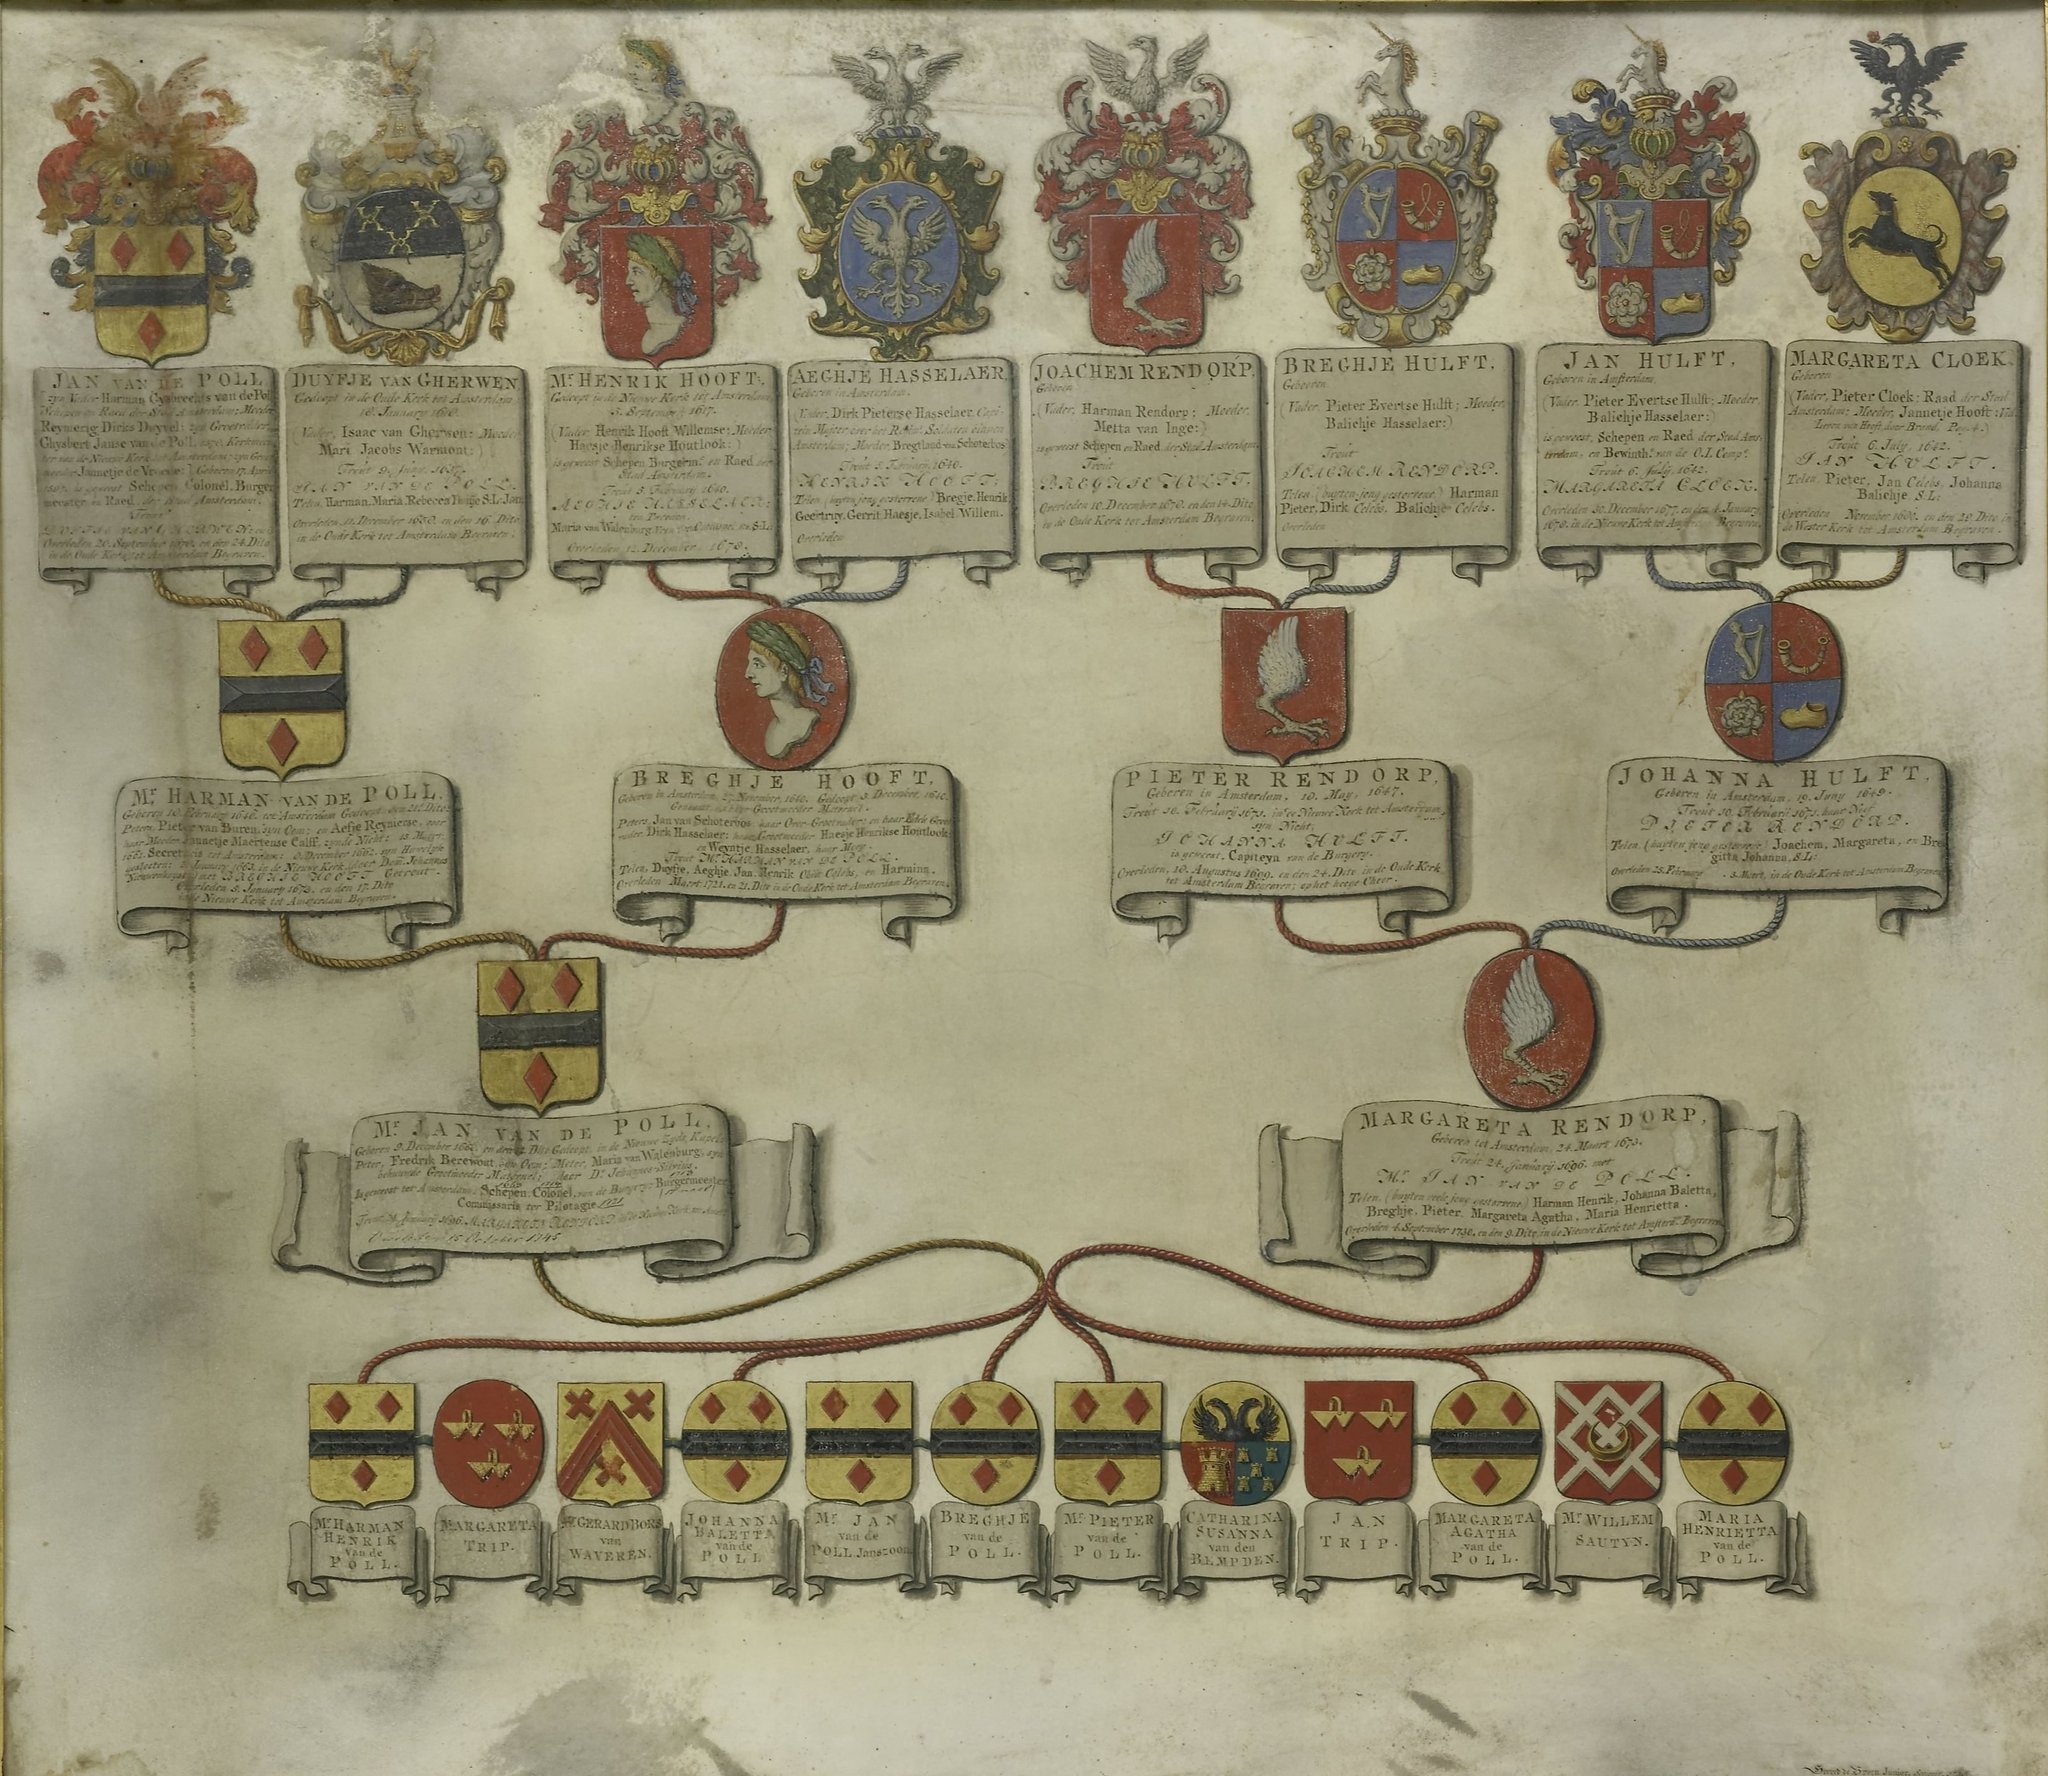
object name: heraldisch object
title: Wapenkaart met de wapens van de zes kinderen van Jan van de Poll en Margaretha Rendorp en die van hun echtgenoten; en hun kwartierstaat met acht kwartieren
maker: gerrit de broen (ii)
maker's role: print maker, publisher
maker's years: 1692-1774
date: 1738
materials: ink, parchment, watercolor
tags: amsterdam, mayor, family lineage, pedigree, genealogical tree or table, armorial bearing, heraldry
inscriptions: signature and date: ‘Gerred de Broen Junior Scripsit 1738’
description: Wapenkaart versierd met de wapens van de zes kinderen van Jan van de Poll (1668-1745) en Margaretha Rendorp (1673-1730) en die van hun echtgenoten: Trip, Bors van Waveren, van de Poll, van den Bempden, Trip en Sautijn; en hun kwartierstaat met acht kwartieren: van de Poll, van Gherwen, Hooft, Hasselaer, Rendorp, Hulft en Cloek. Onderdeel van een groep van drie wapens behorend bij de schenking J.S.R. van de Poll, Arnhem, 1885 (SK-A-1276/1278). Onderdeel van de collectie heraldische objecten.